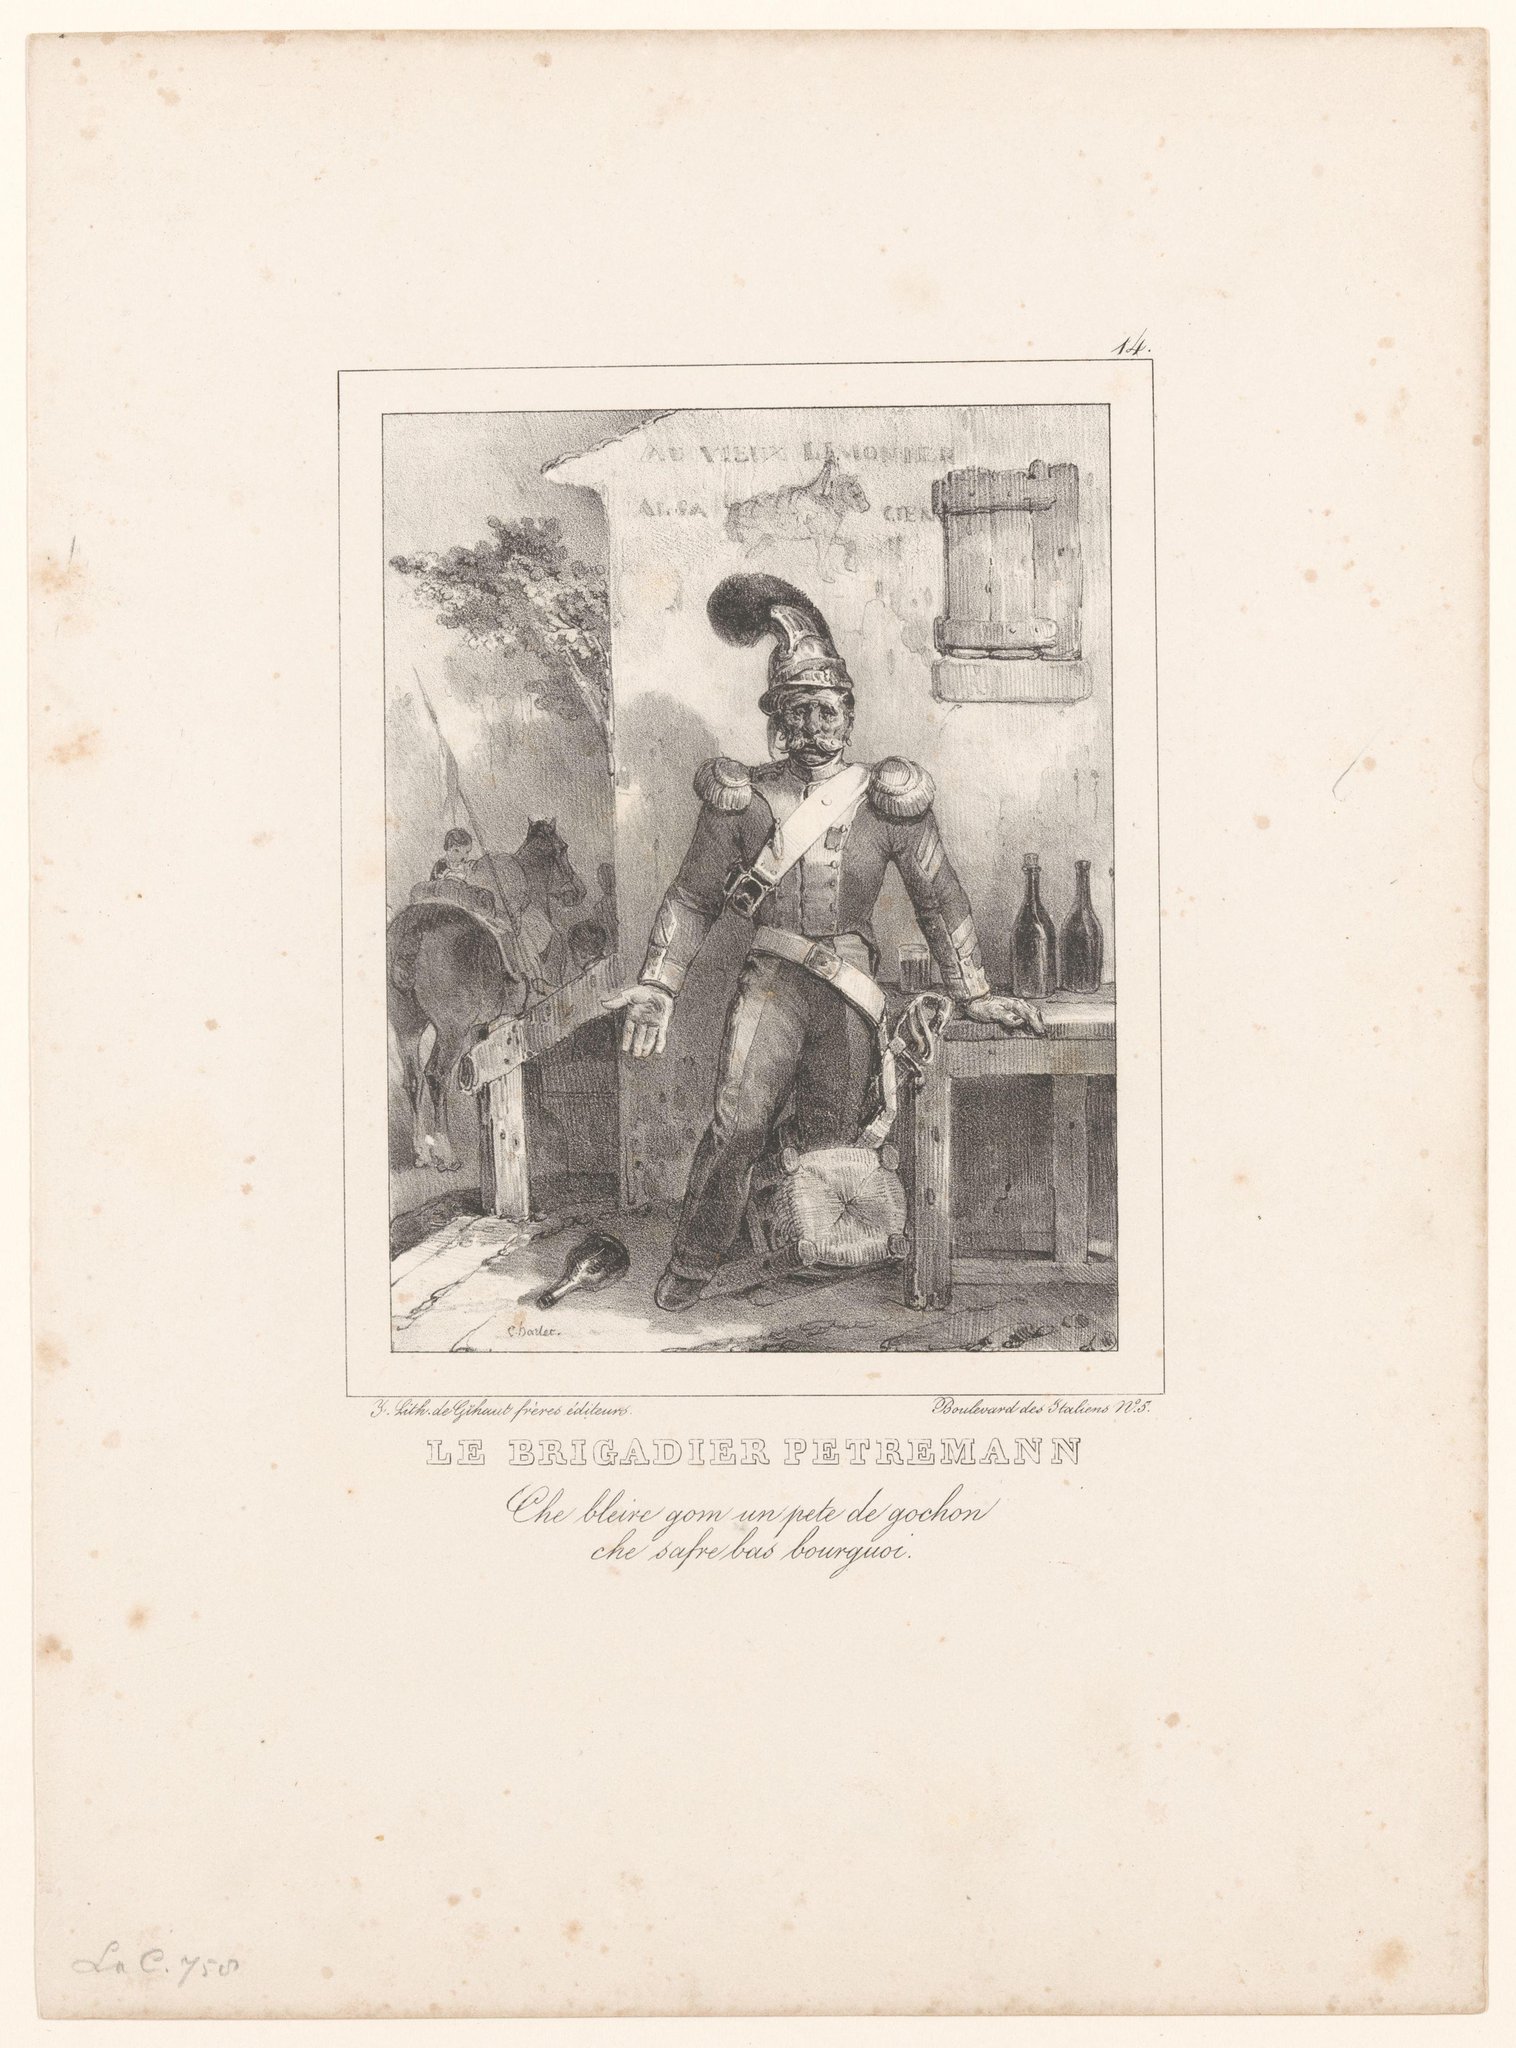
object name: print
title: Lithografisch album 1830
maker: nicolas toussaint charlet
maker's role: draughtsman, painter, print maker, printer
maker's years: 1792-1845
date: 1830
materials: paper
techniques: lithograph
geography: paris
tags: canteen ~ the soldier off duty, drunkard, private soldier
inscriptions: collector's mark: Lugt 2228a